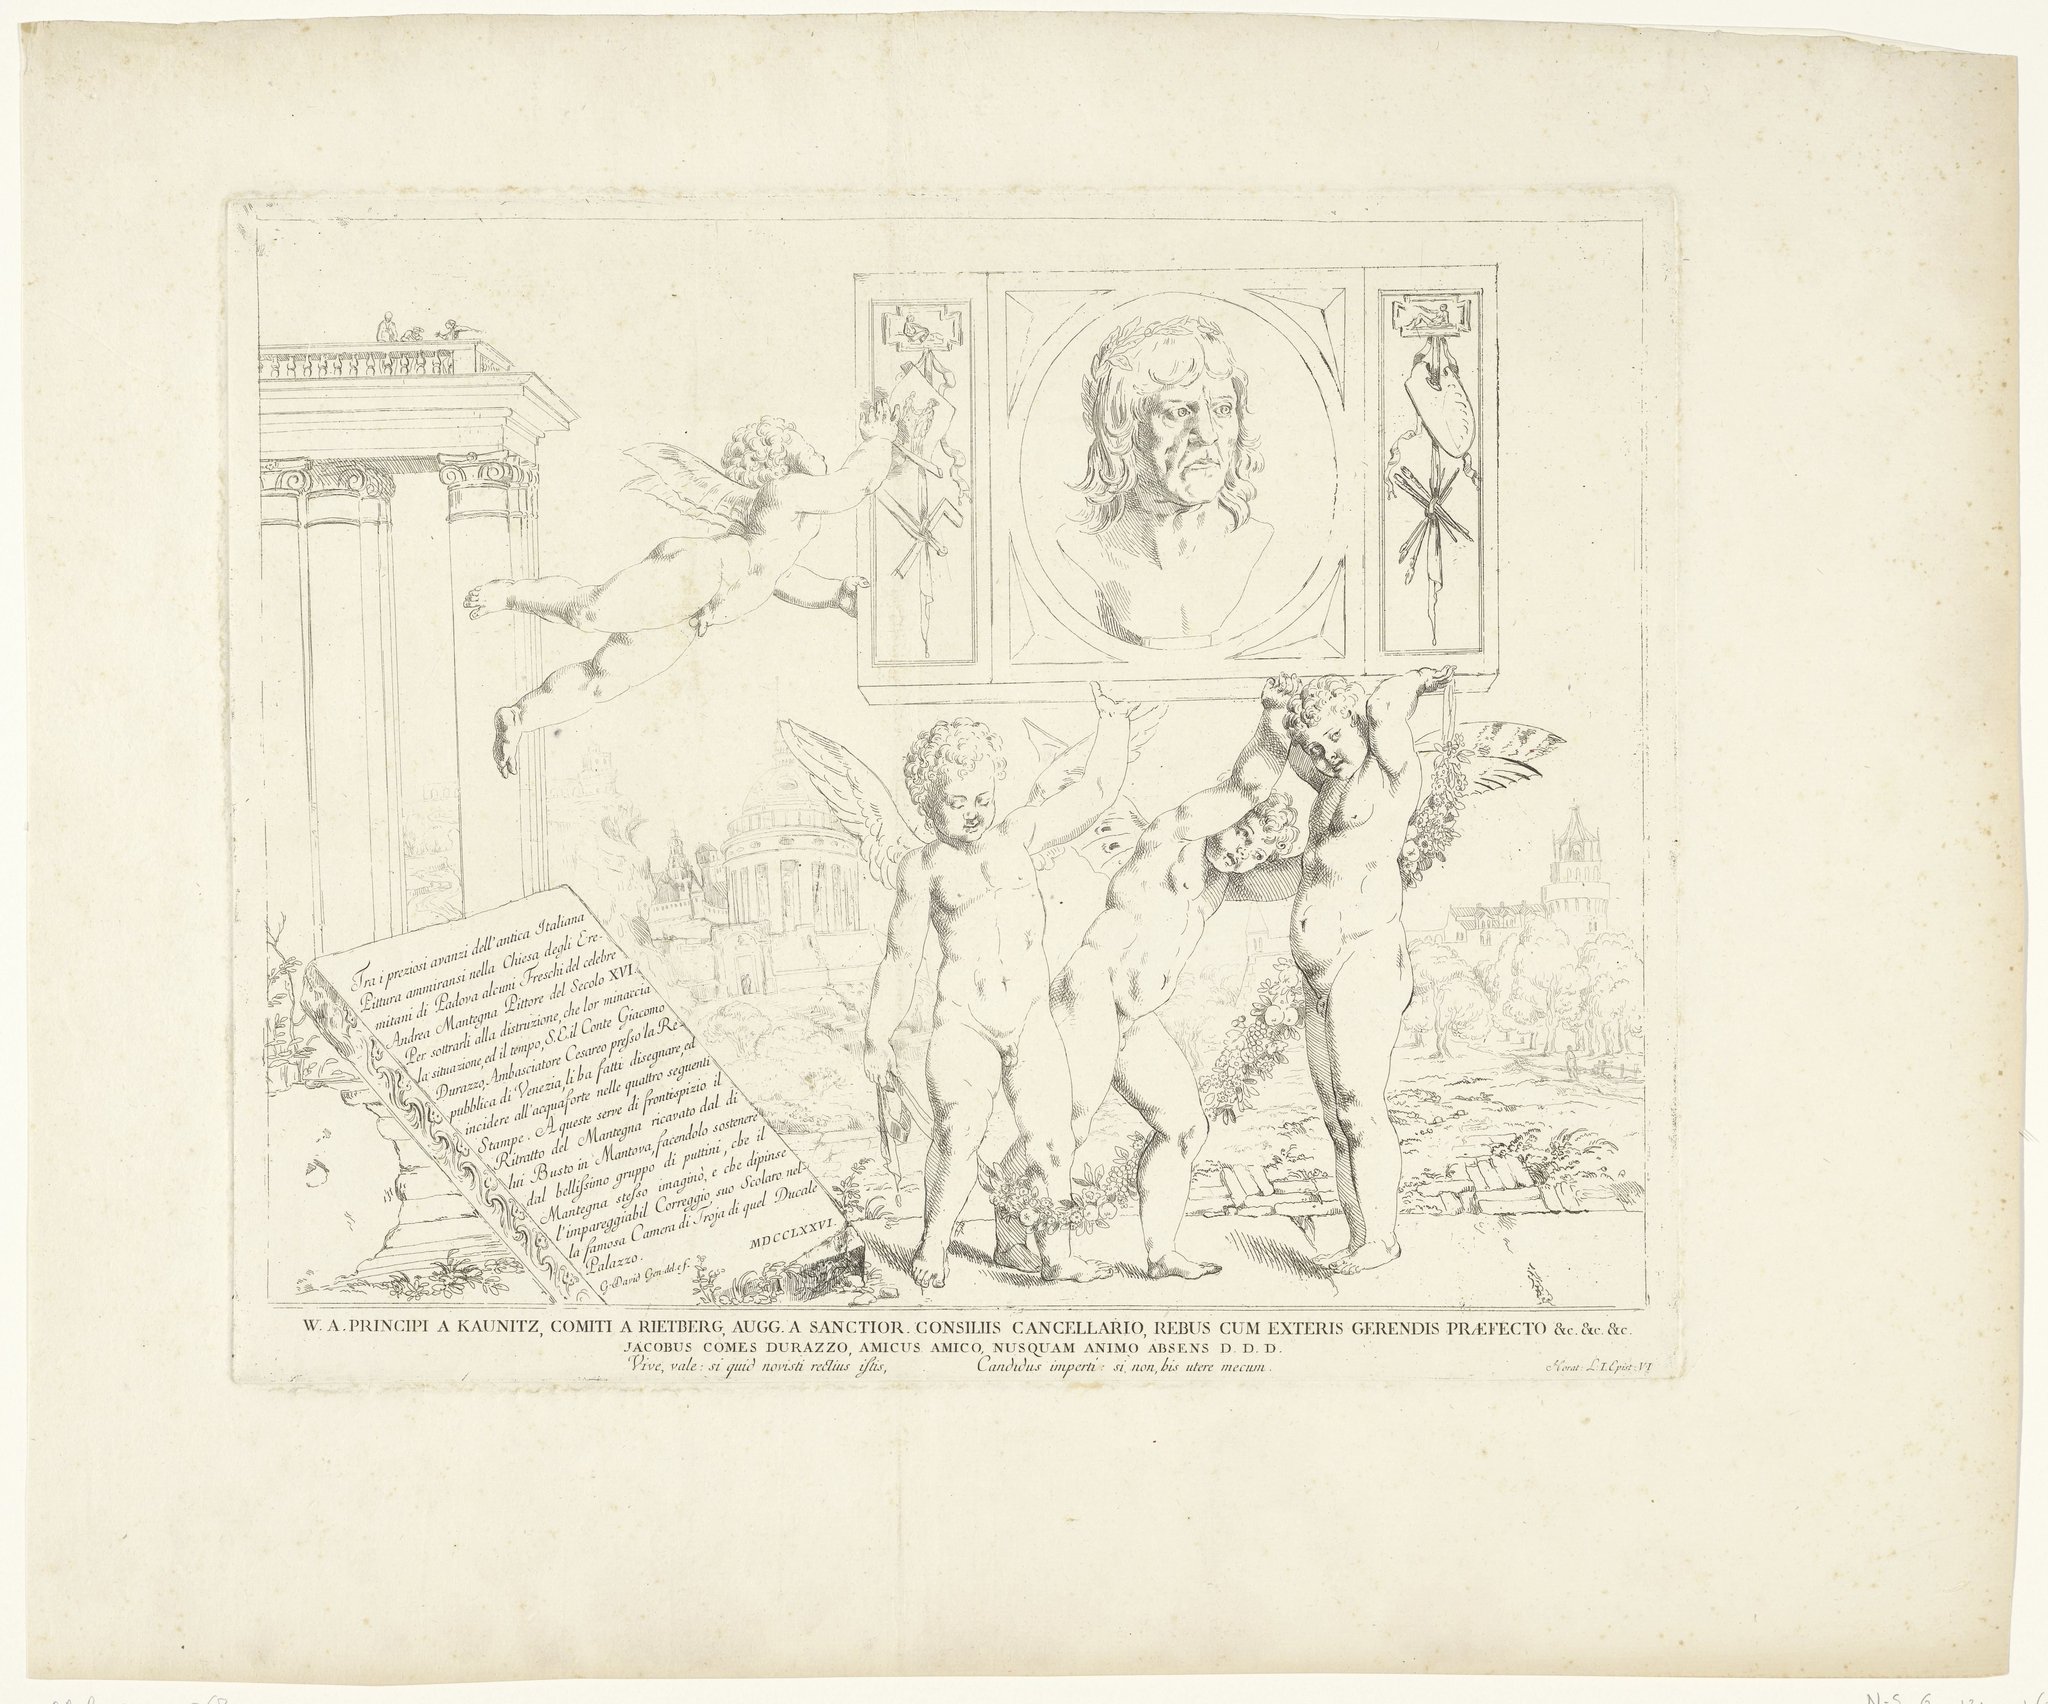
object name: titelprent, frontispice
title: De fresco's van Andrea Mantegna in de Chiesa degli Eremitani in Padua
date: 1776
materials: paper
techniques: etching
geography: italy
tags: andrea mantegna, tools, implements of painter, portrait, self-portrait of artist, cupids: 'amores', 'amoretti', 'putti'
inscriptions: collector's mark: Lugt 2228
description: Titelblad bij een reeks van vier prenten met weergaven van de fresco's van Andrea Mantegna in de Chiesa degli Eremitani in Padua (fresco's zijn vernietigd tijdens bombardement 11 maart 1944). David maakte de prentreeks naar de in 18de eeuw al door luchtvervuiling bedreigde fresco's in opdracht van graaf Jacobi Durazzo. Deze titelprent is zelf geen contra-épreuve, maar gaat vooraf aan reeks van unieke(?) contra-épreuves in het RPK, die Mantegna's voorstellingen in dezelfde richting weergeven. Het titelblad werd waarschijnlijk niet als contra-épreuve gedrukt vanwege de leesbaarheid van de uitvoerige opschriften. Het portret van Mantegna is ontleend aan de bronzen buste van de kunstenaar in de Sant'Andrea te Mantova en de putti aan het fresco in de Camera degli Sposi.